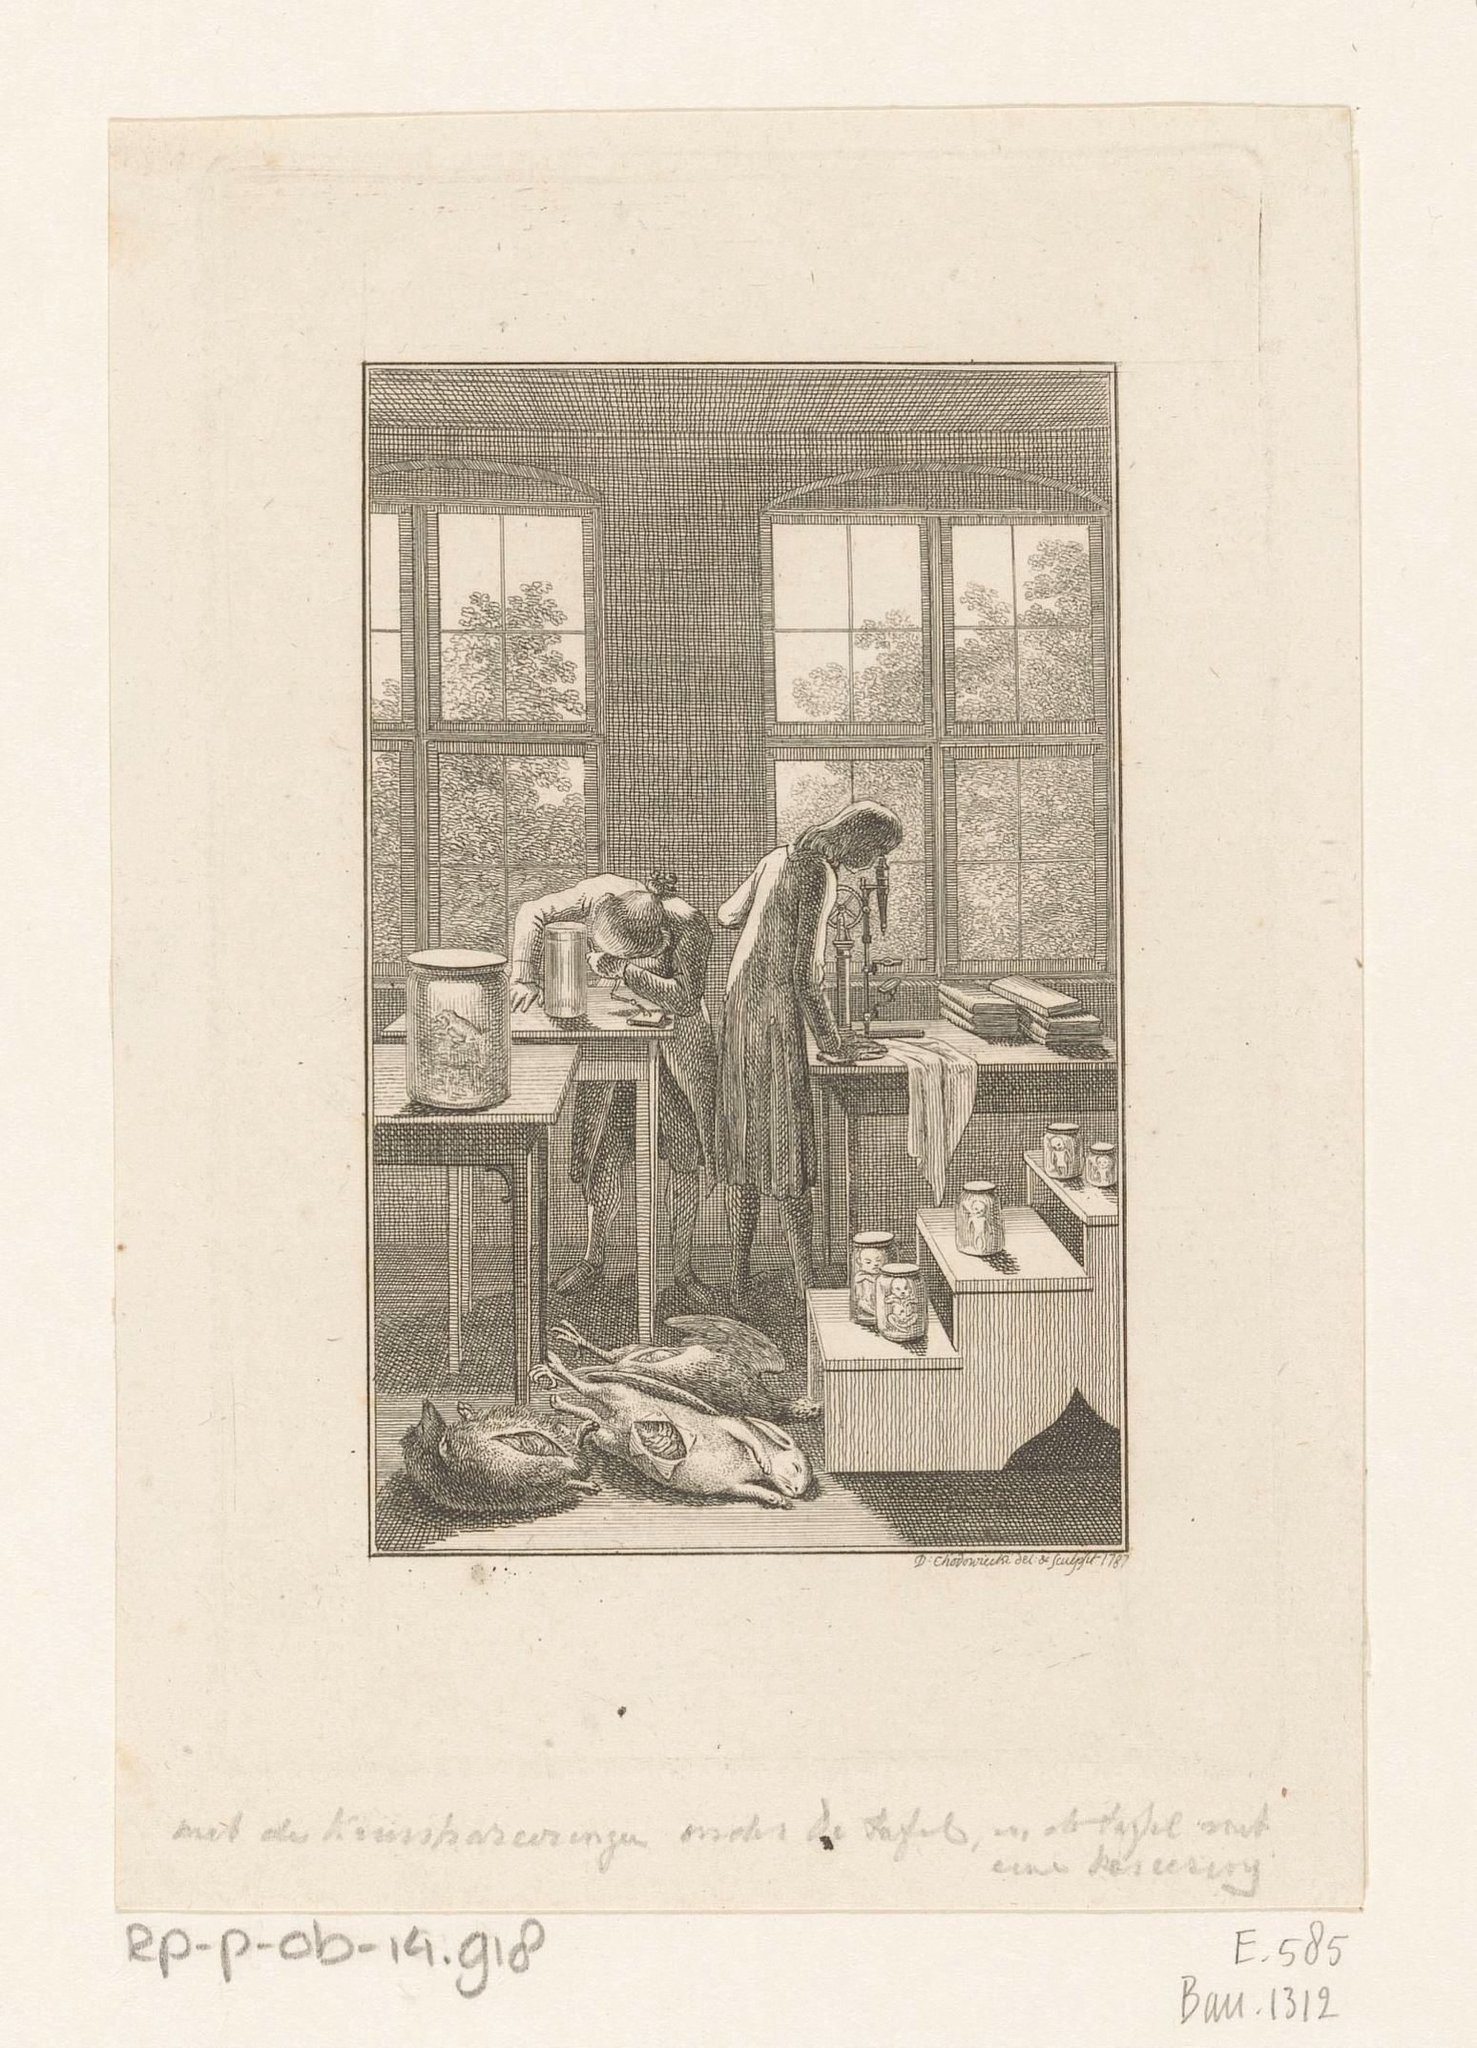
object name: print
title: Twee natuurkundigen, om hen heen ontlede dieren en baby's op sterkwater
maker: daniel nikolaus chodowiecki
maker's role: draughtsman, print maker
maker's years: 1726-1801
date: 1787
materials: paper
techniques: etching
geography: berlin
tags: physicist, physiology and anatomy (+ scholar, scientist (at work)), dissection, interior of the house, laboratory, research room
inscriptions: collector's mark: Lugt 2228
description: Volgens de beschikbare literatuur zou deze prent behoren tot 'Naturgeschichte' van Johann Friedrich Blumenbach, maar de daadwerkelijke publicatie wordt niet genoemd.